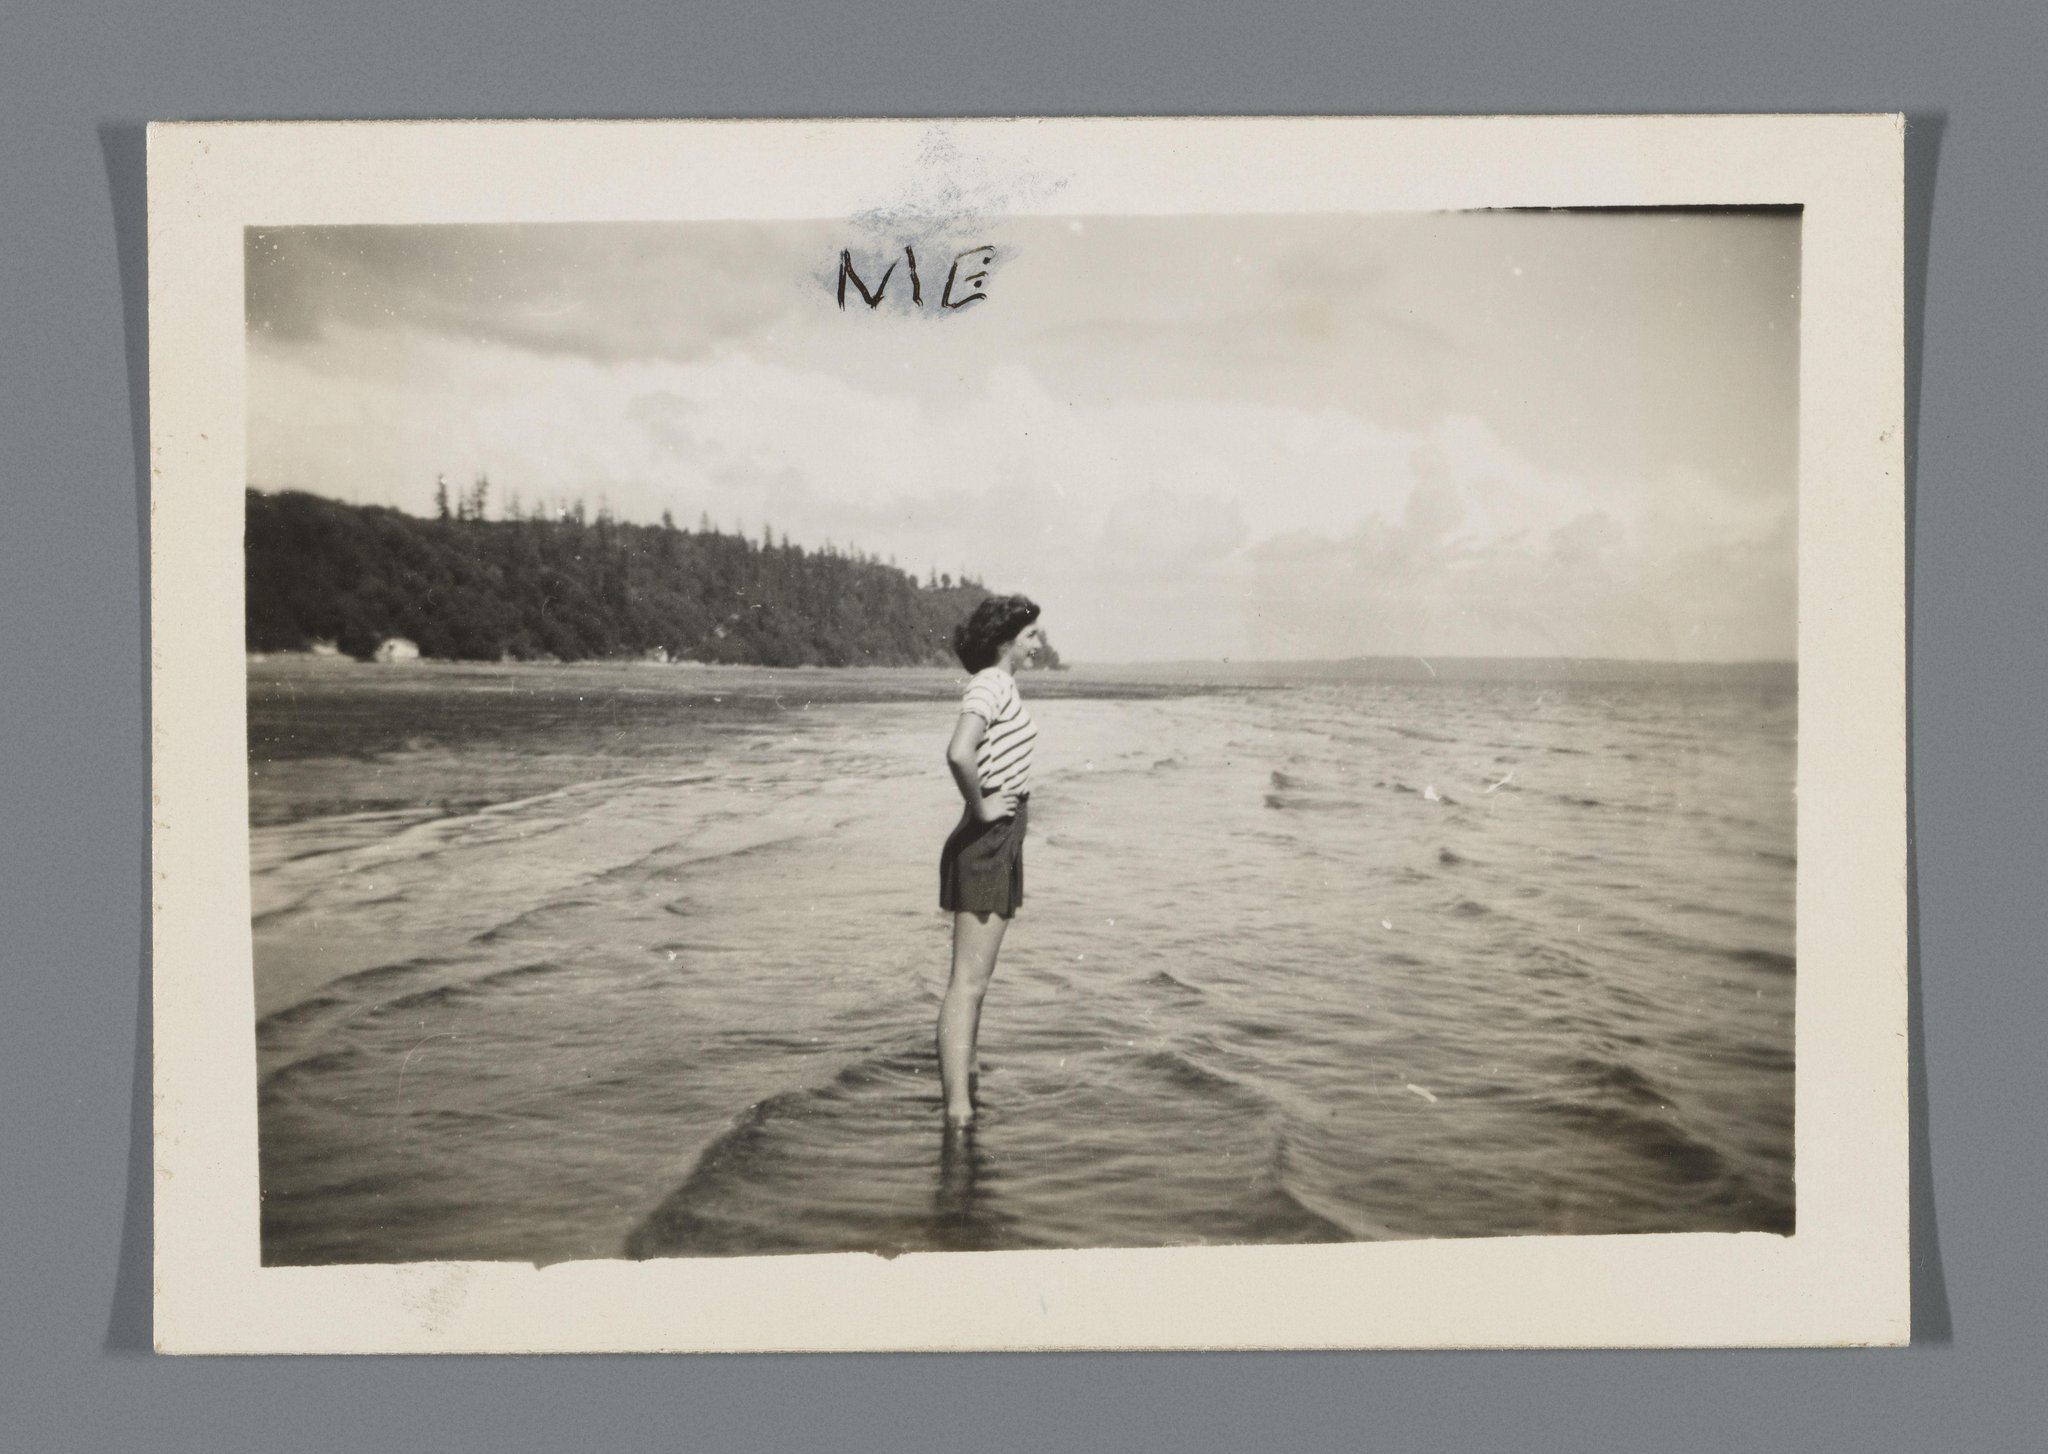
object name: photograph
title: Vrouw staand aan de rand van een meer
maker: Anonymous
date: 1930-1945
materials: paper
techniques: gelatin silver print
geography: united states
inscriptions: inscription: ‘me’